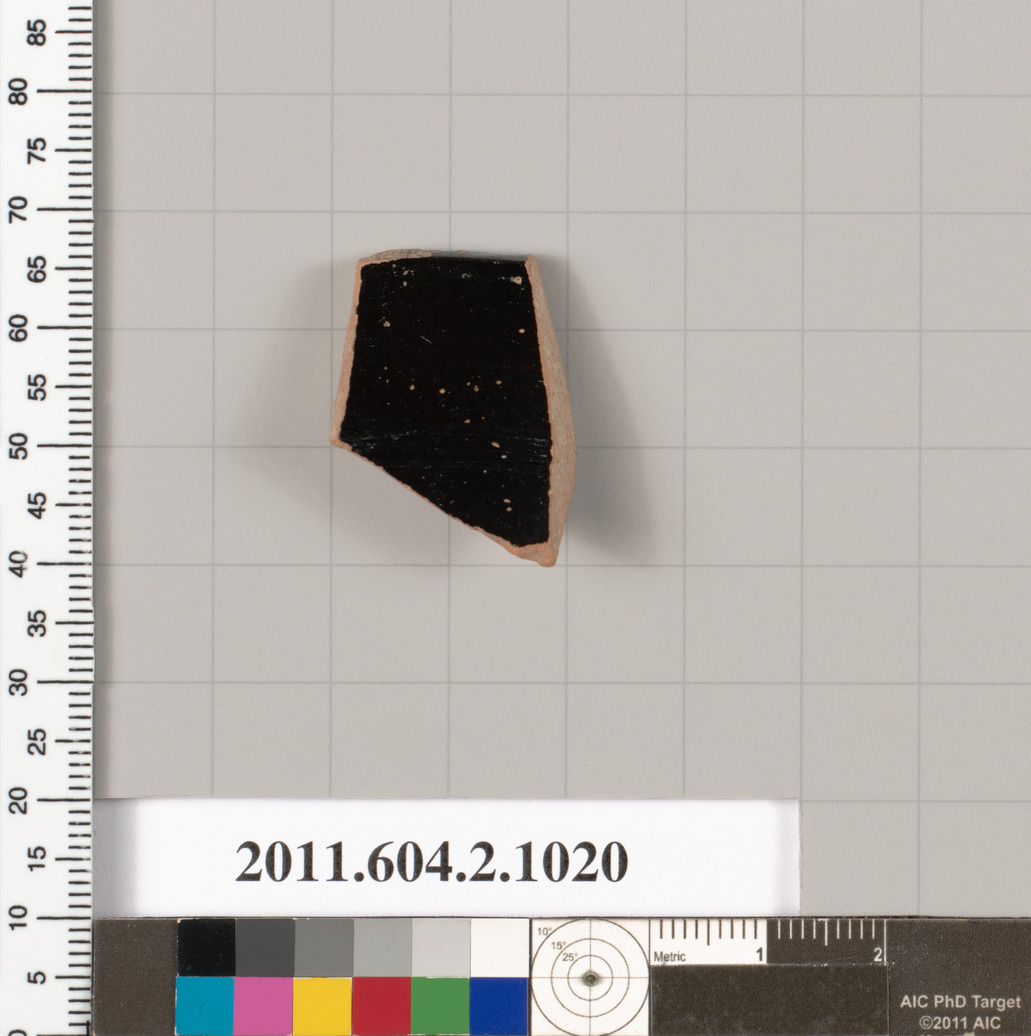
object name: oinochoe fragment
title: Terracotta rim fragment of an oinochoe (jug)?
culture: greek, attic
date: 475-425 BCE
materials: terracotta